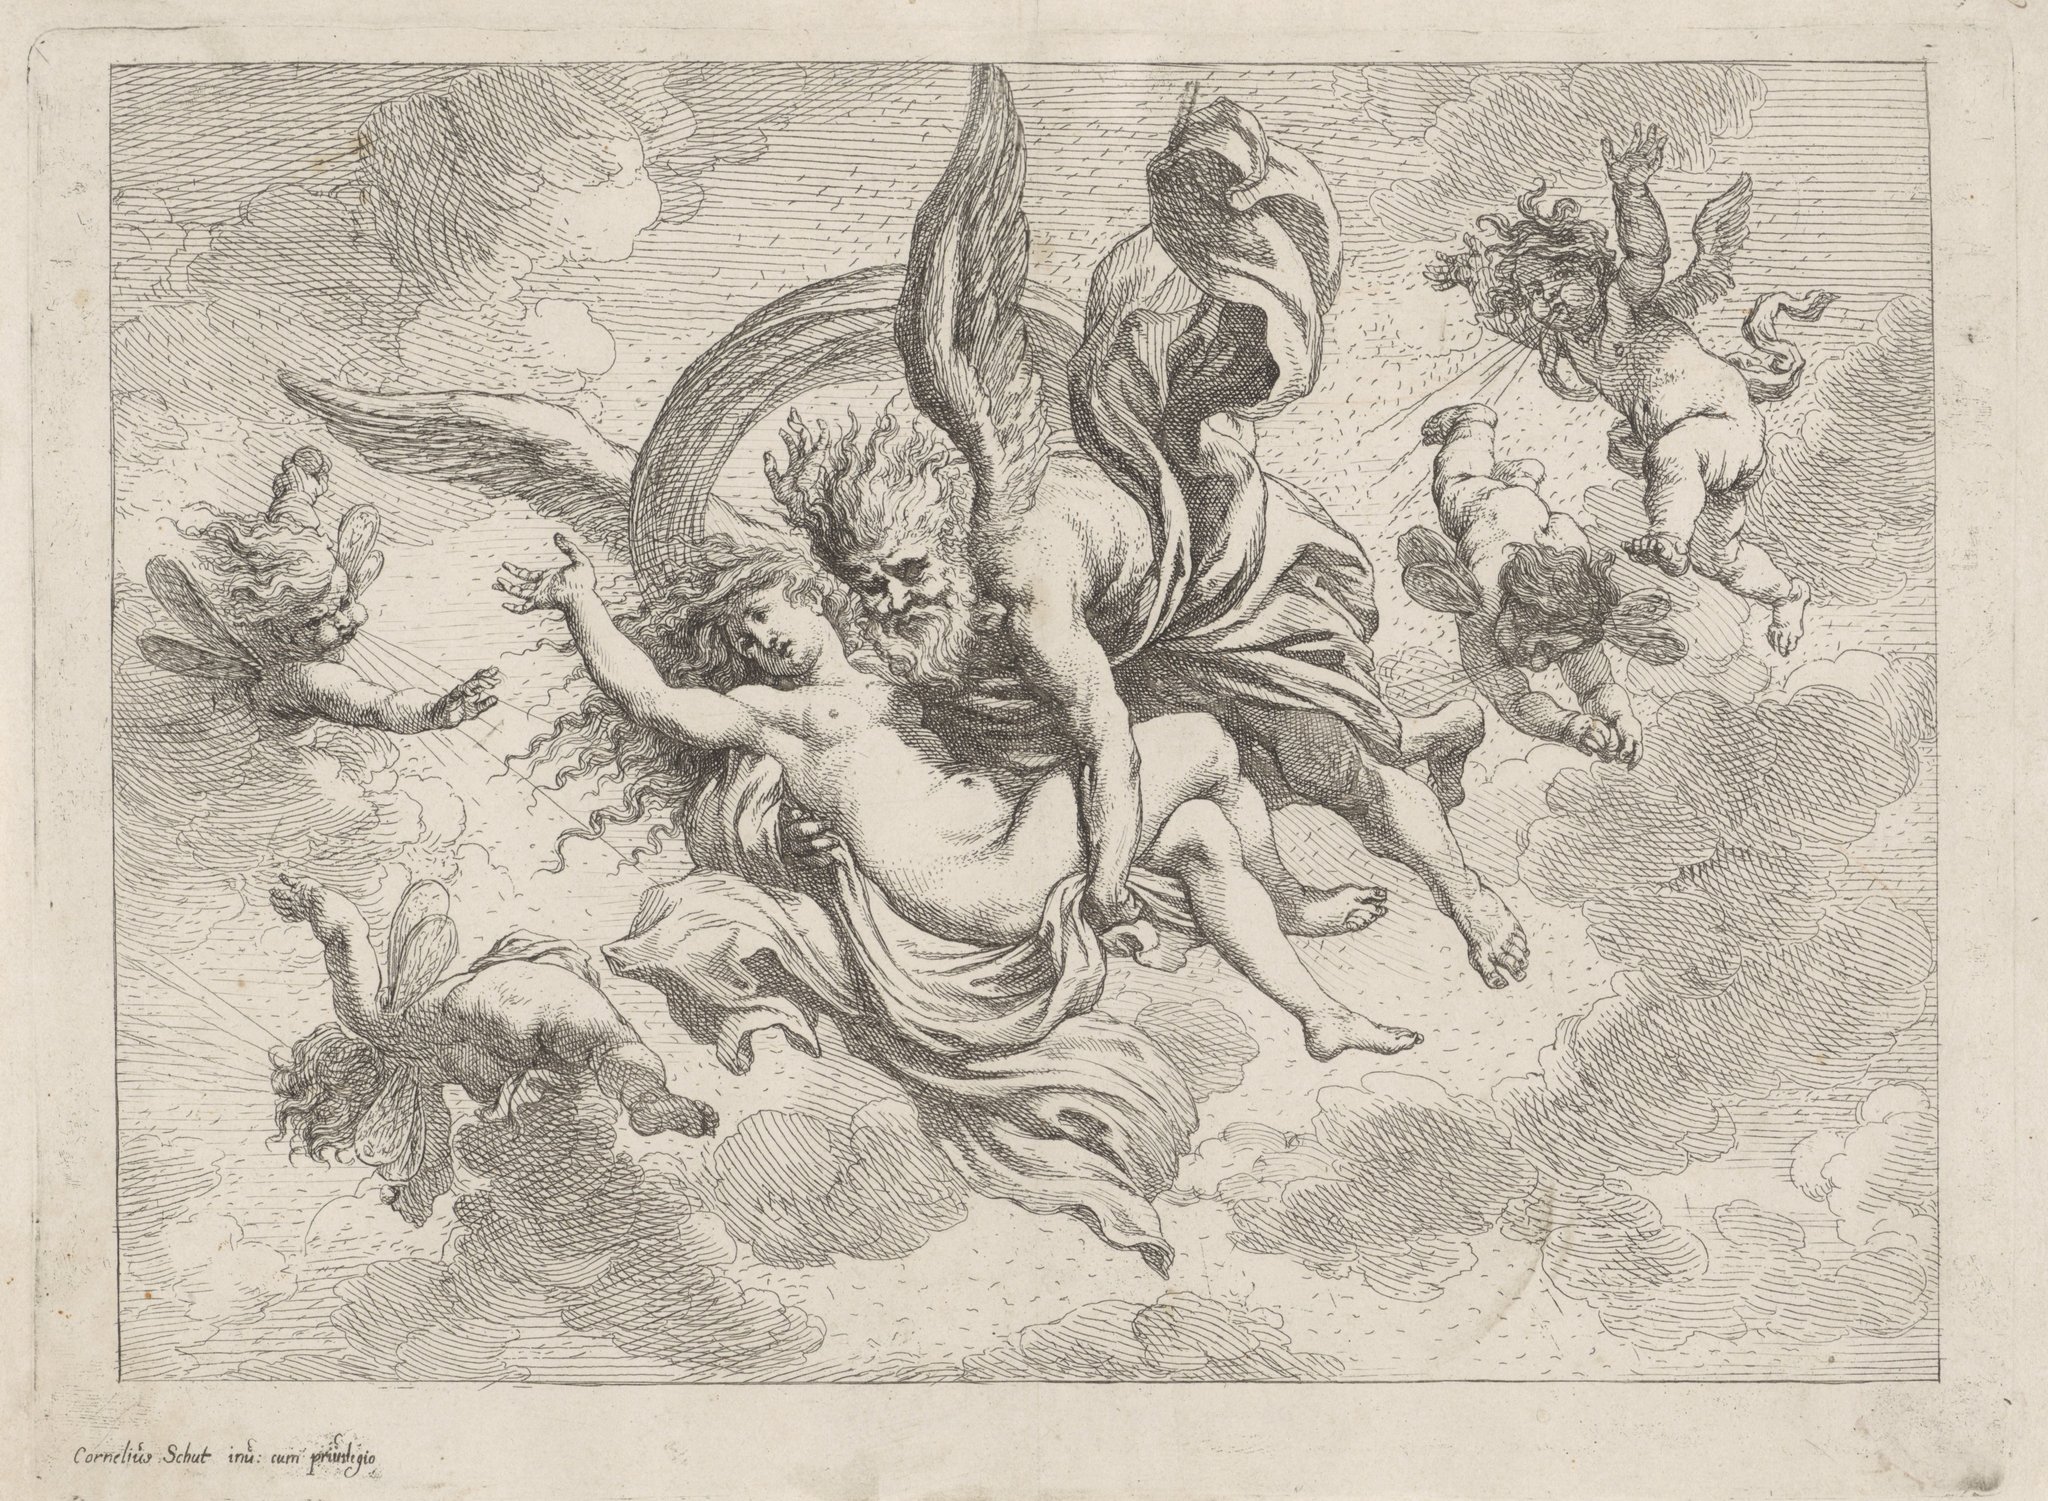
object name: print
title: Boreas en Oreithyia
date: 1618-1655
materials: paper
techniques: engraving, etching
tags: boreas abducting orithyia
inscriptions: collector's mark: Lugt 240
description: Boreas vliegt weg met de wanhopige Oreithyia in zijn armen. Om hen heen vliegen blazende putti.